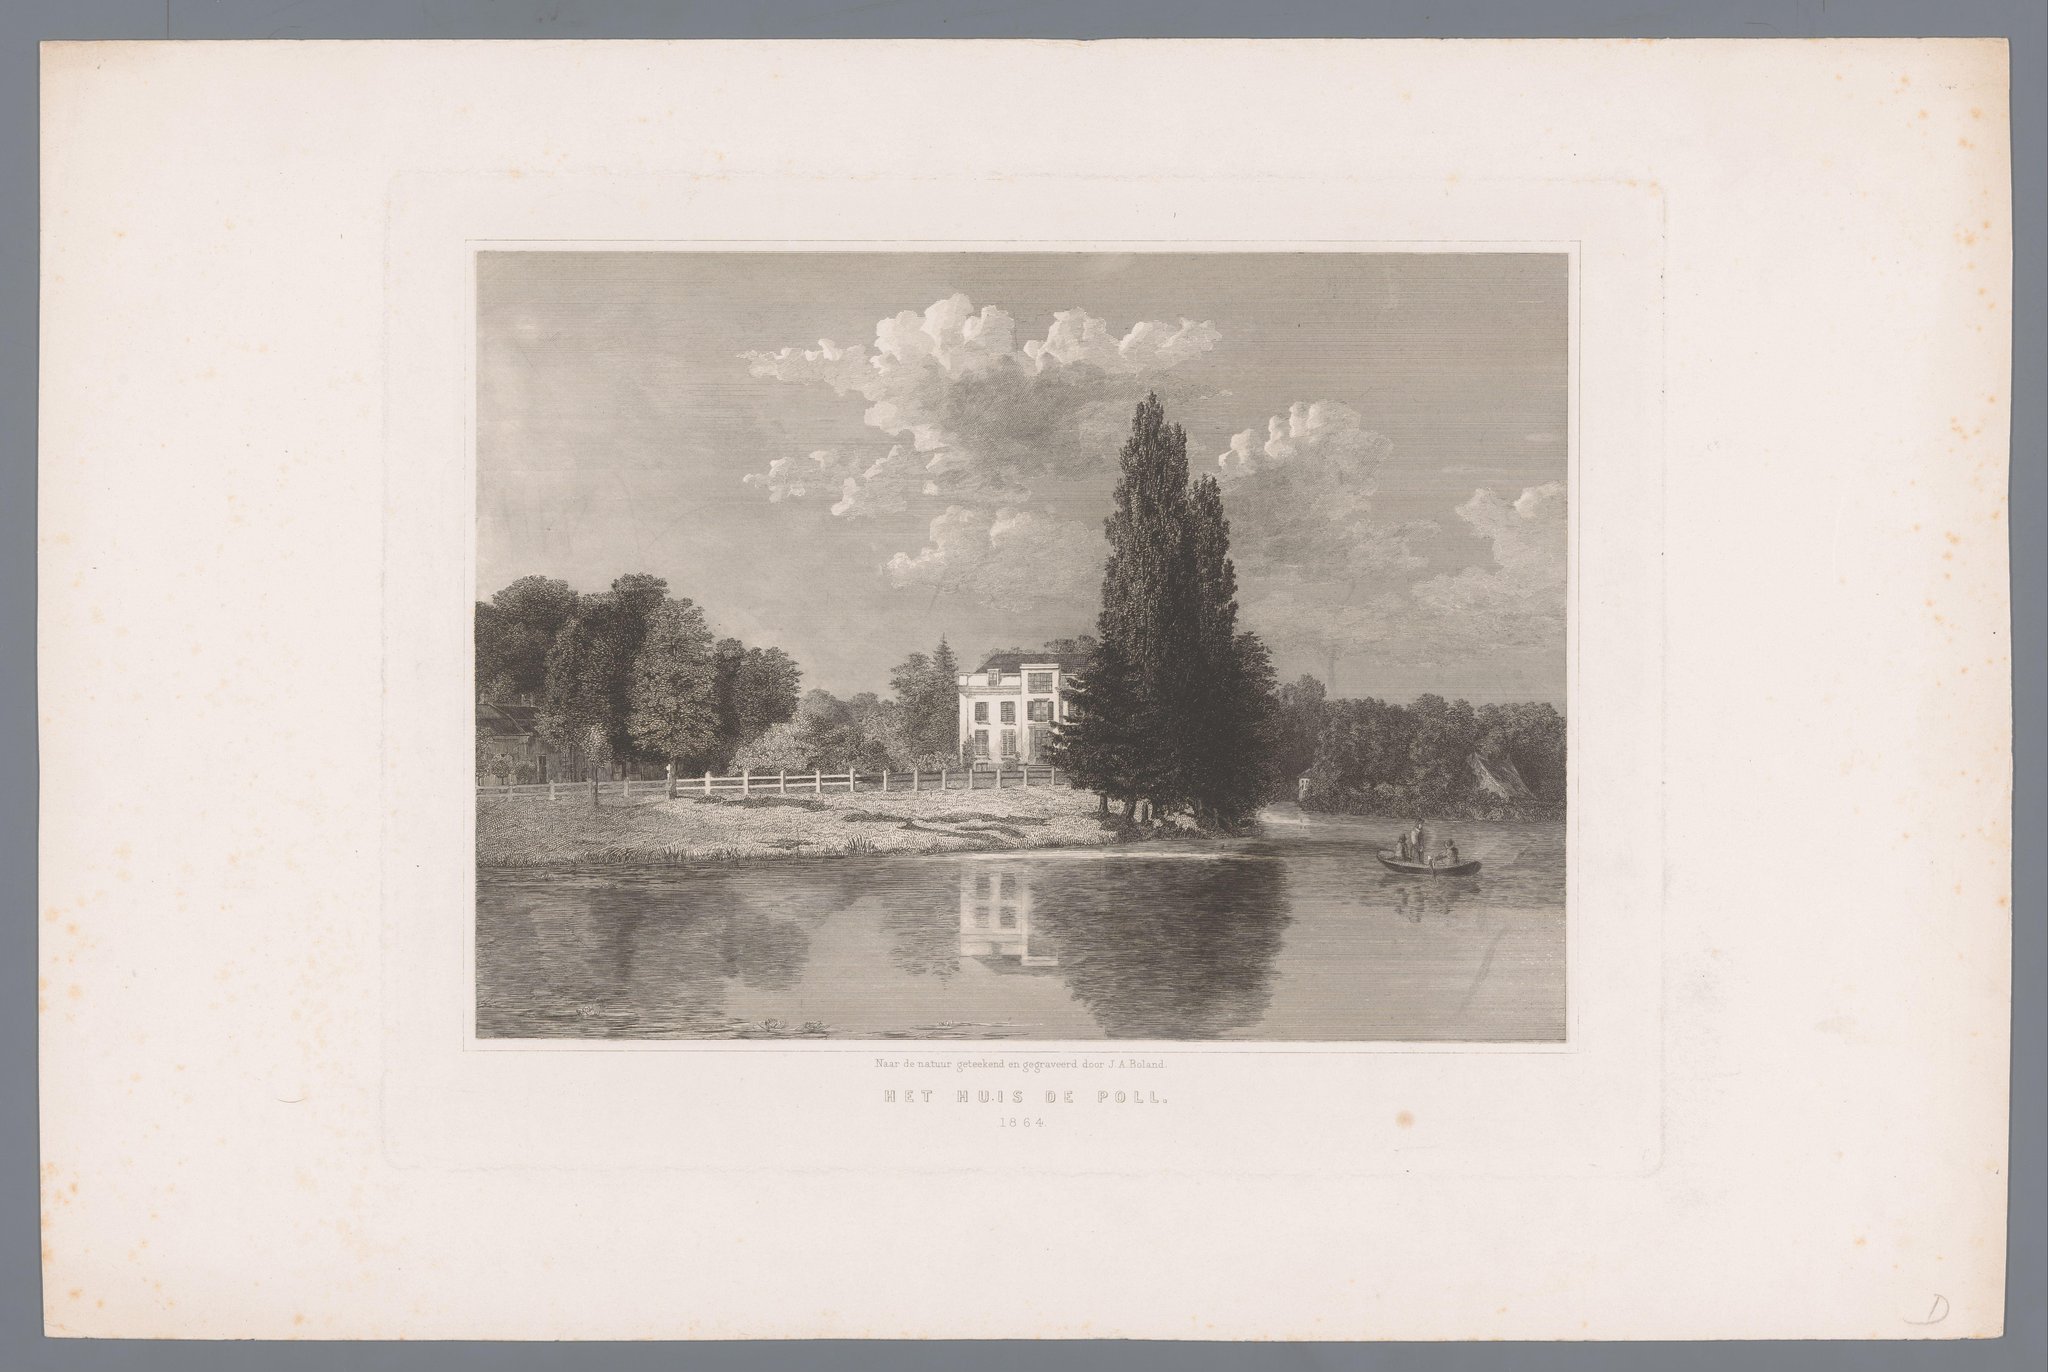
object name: print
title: Gezicht op het Huis de Poll onder Voorst van voren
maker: johannes arnoldus boland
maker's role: print maker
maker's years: 1838-1922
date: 1864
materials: paper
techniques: engraving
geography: amsterdam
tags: rural housing, e.g. country-house, villa, cottage, lake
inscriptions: date